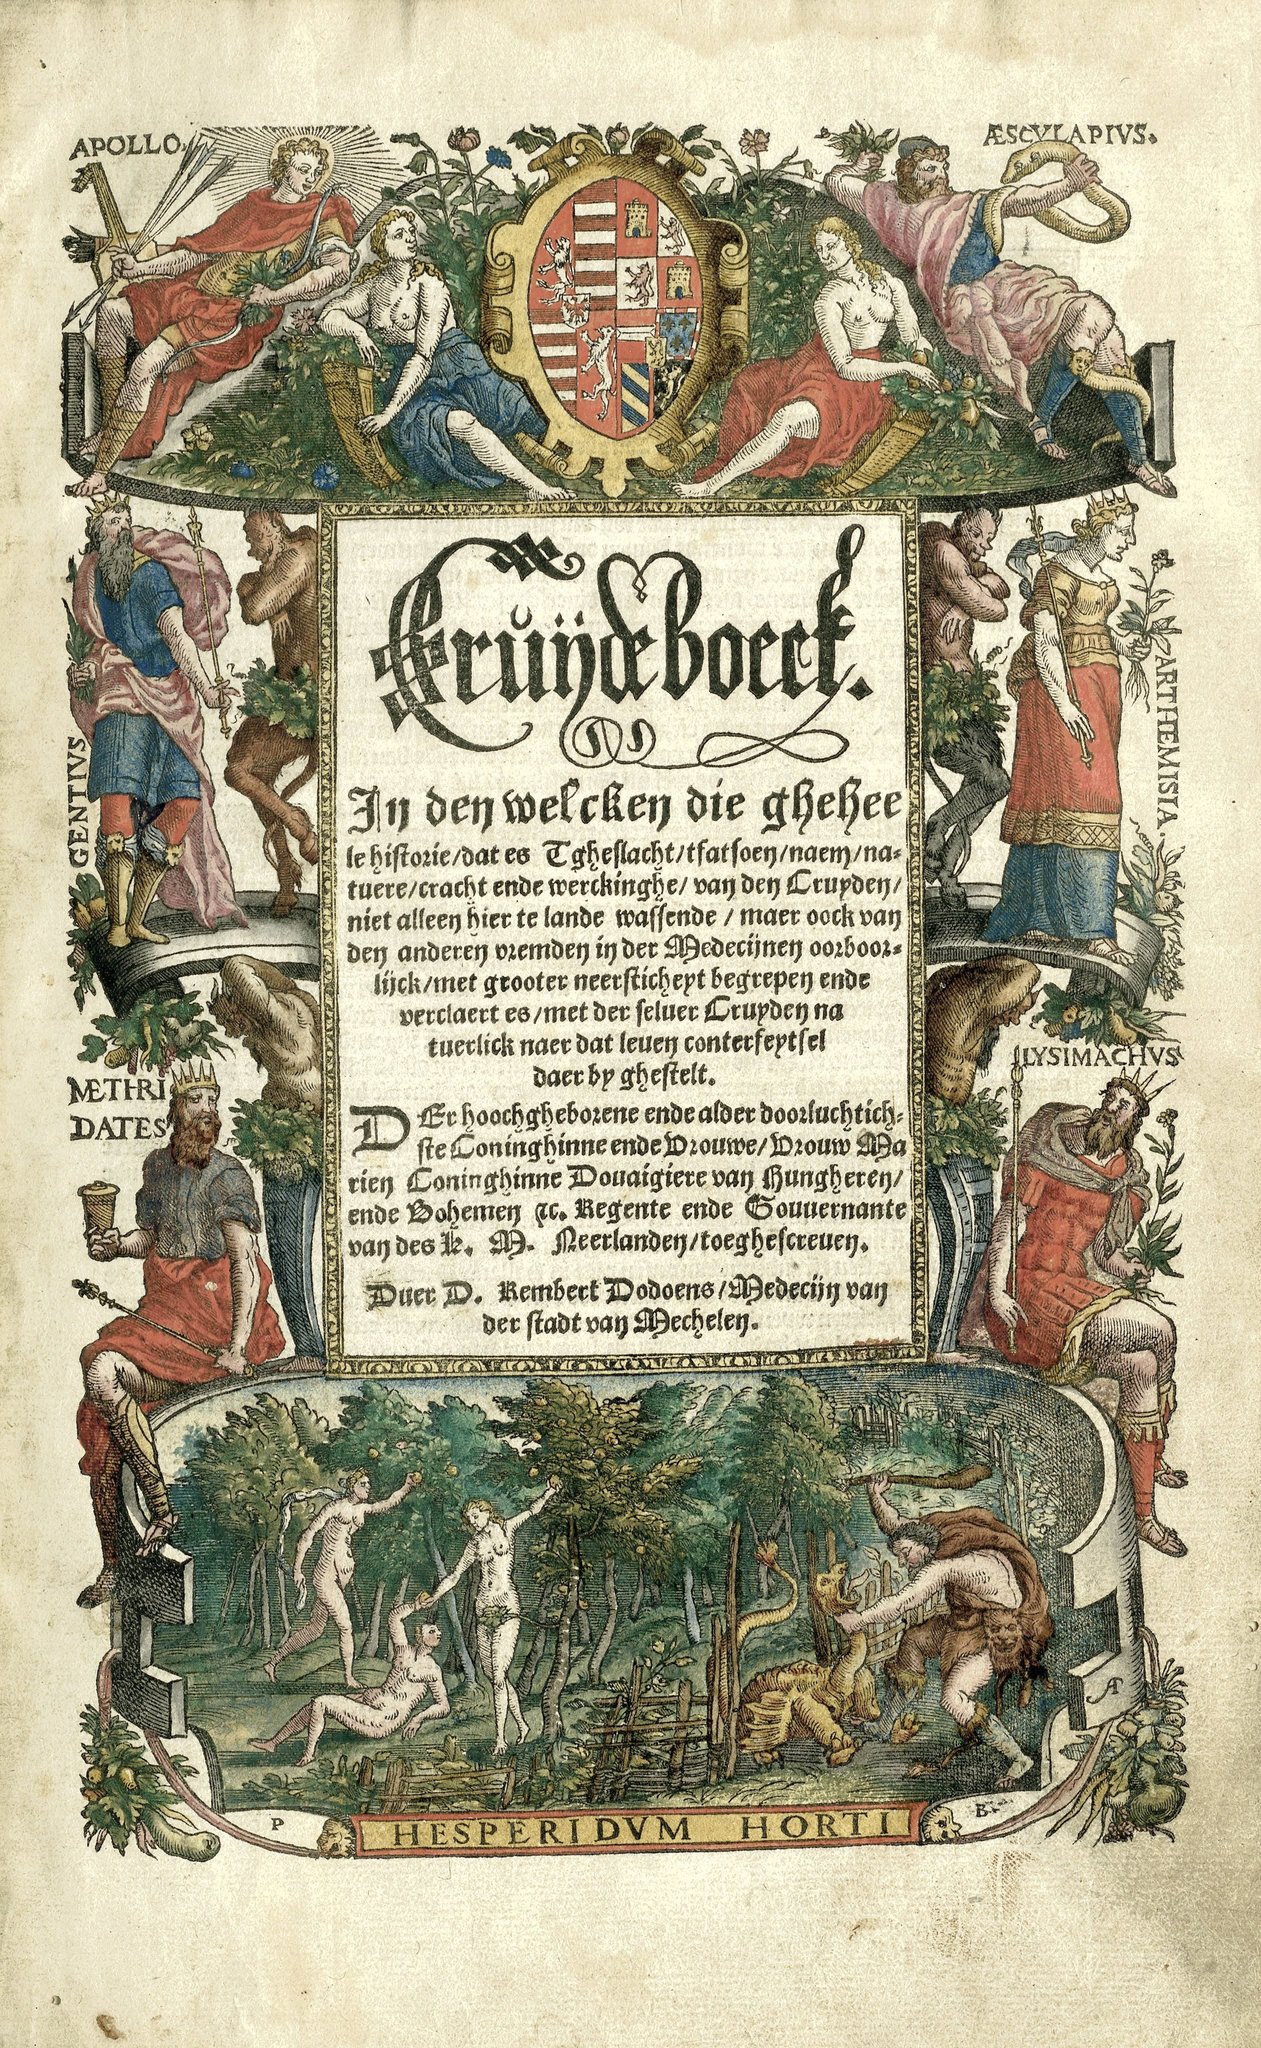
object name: book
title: Dodoens Cruijdeboeck met voorstellingen van planten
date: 1567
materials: leather, linen, paper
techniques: bookbinding, letterpress printing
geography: antwerp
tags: botany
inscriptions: collector's mark: Lugt 2228, label: ‘J.H. Krelage’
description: Het kruidboek van Rembert Dodoens, getiteld: Cruijdeboeck in den welcken die gheheele historie, dat is tgheslacht, tfatsoen, naem, natuere, cracht ende werckinghe, van den cruyden, niet alleen hier te lande wassende, maer oock van den anderen vremden in der medecijnen oorboorlijck, met groote neersticheyt begrepen ende verclaert es. Het boek is versierd met 7 titelpagina's en 715 voorstellingen van planten en kruiden. Daarbij initialen en andere ornamenten in houtsnede. Alle houtsnedes zijn met de hand ingekleurd door Hans Liefrinck de jonge. Leren band met voorin en achterin een schutblad.